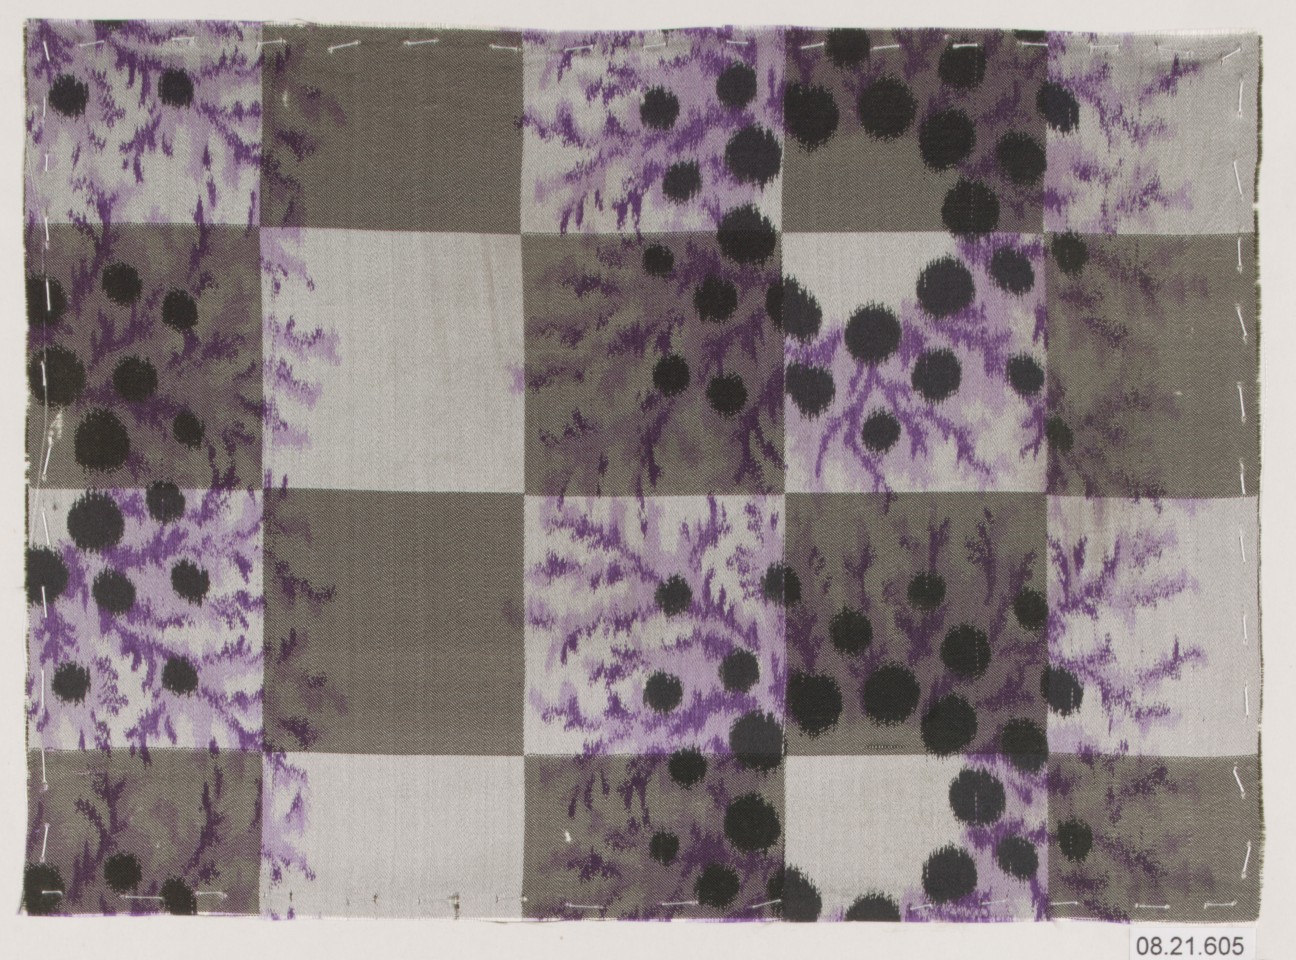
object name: textile sample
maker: Anonymous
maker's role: designer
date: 1900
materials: silk